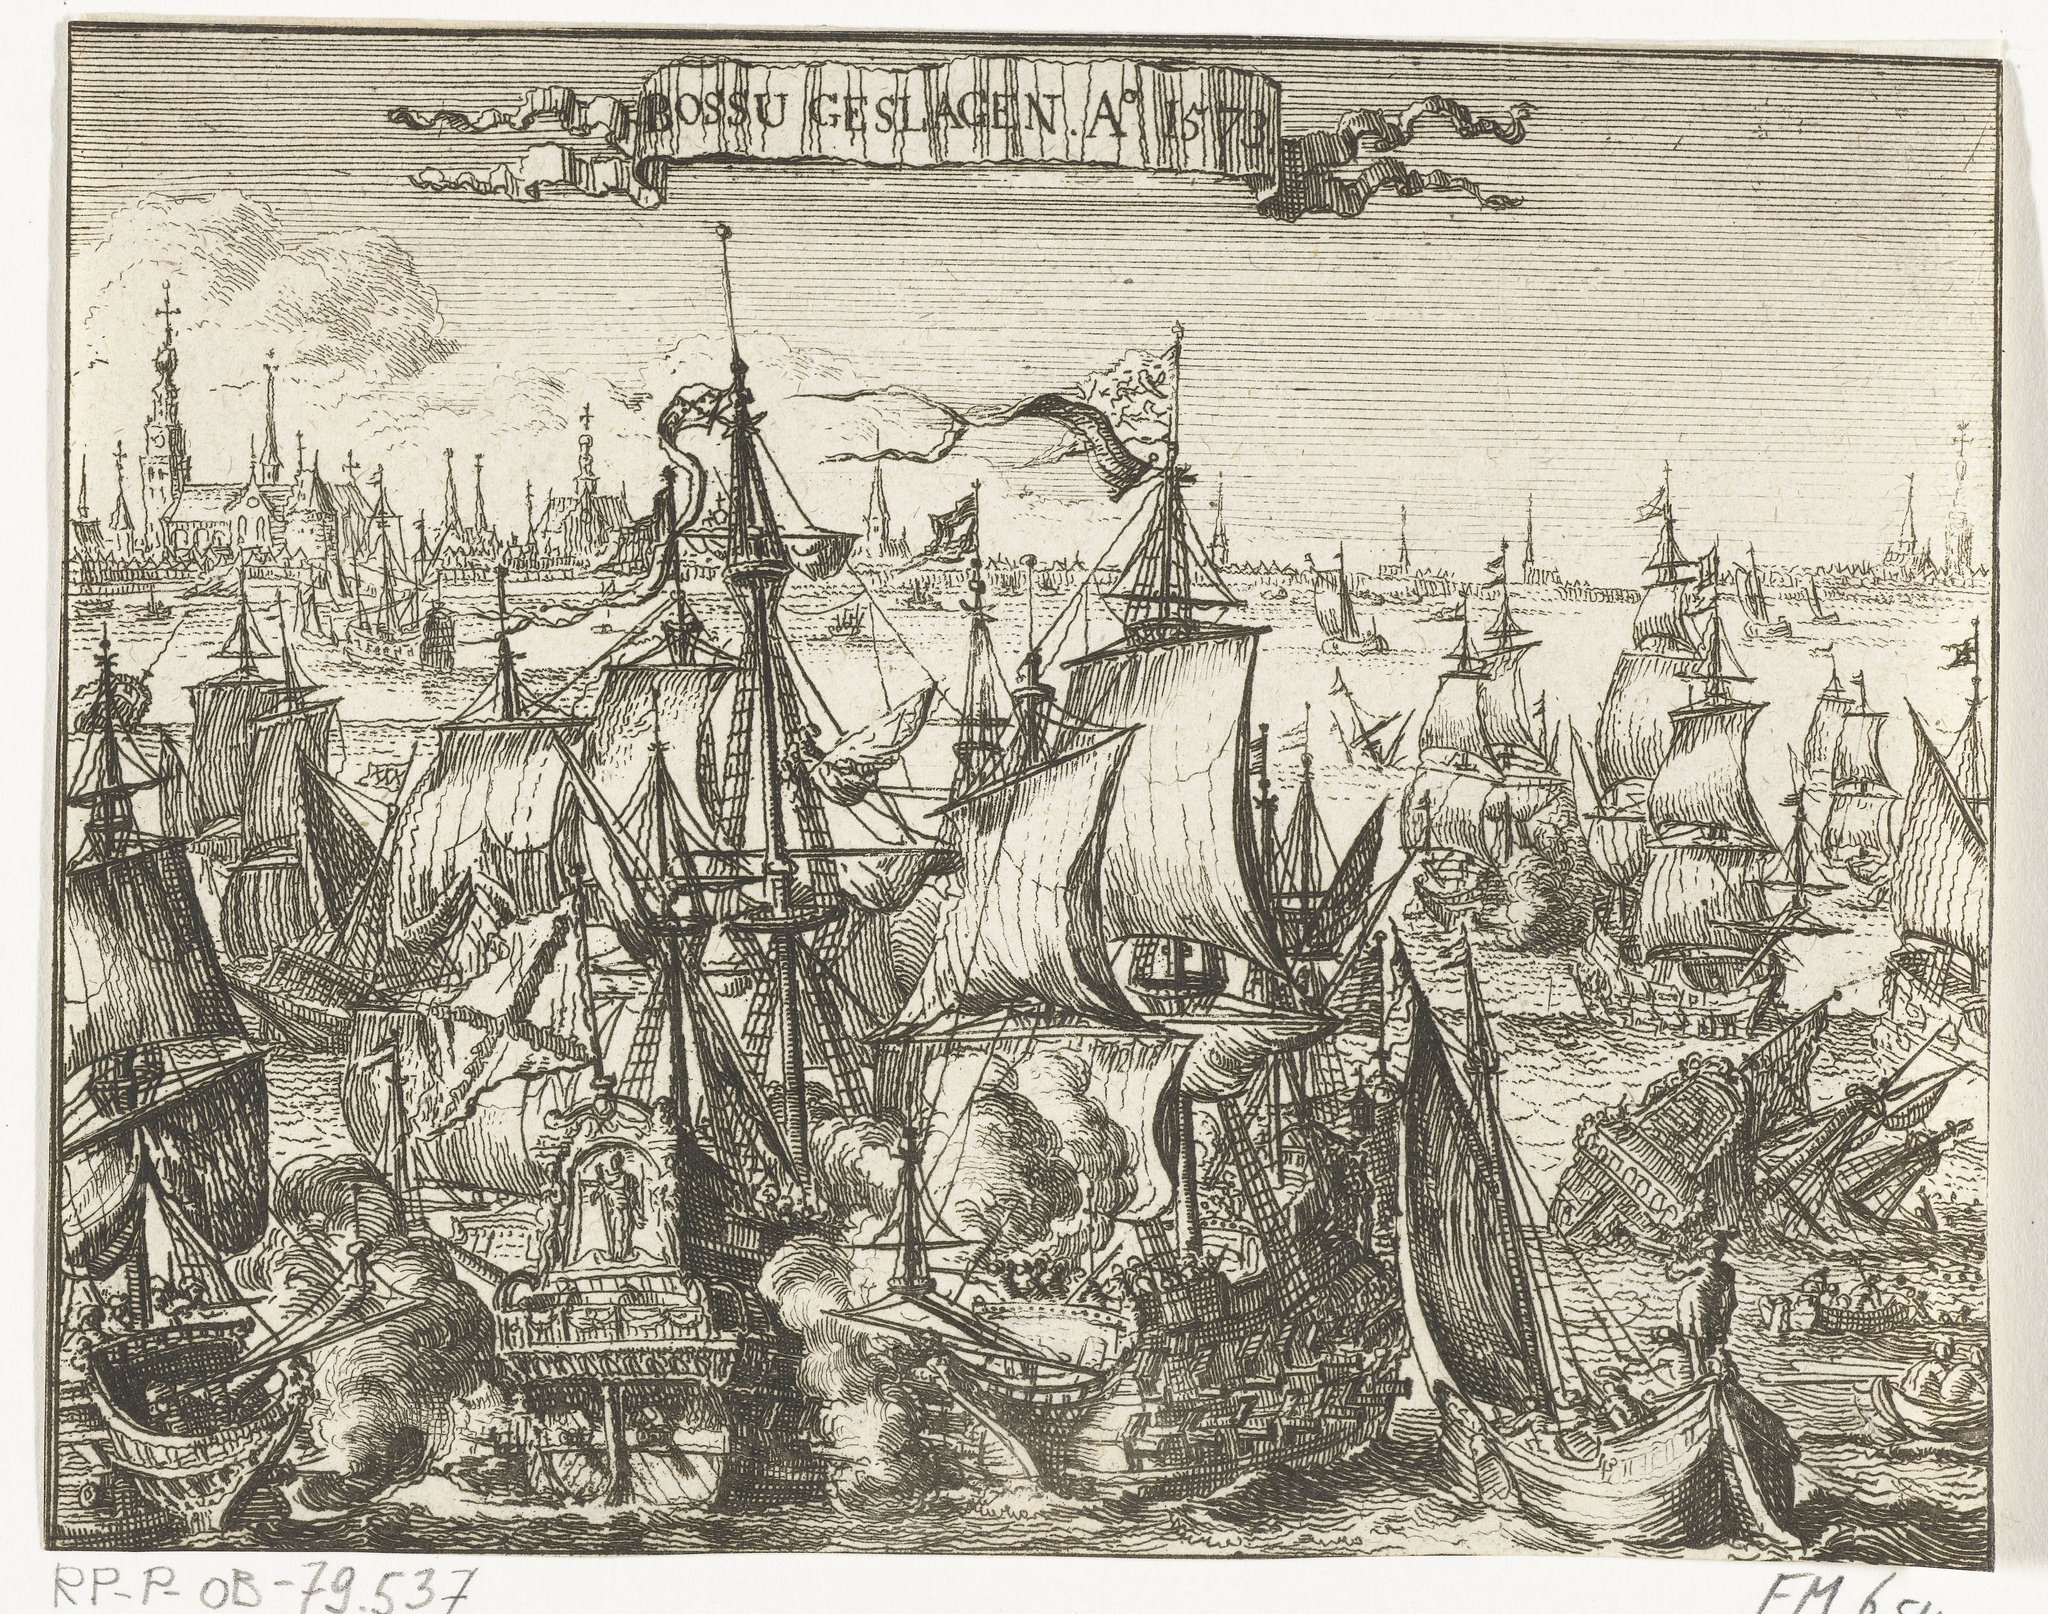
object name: history print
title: Bossu geslagen. Ao. 1573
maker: romeyn de hooghe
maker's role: draughtsman, goldsmith, painter, print maker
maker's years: 1645-1708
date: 1704-1706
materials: paper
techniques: etching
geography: northern netherlands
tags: antwerp, earl, politician, battle (+ naval force), zuiderzee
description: De slag op de Zuiderzee, 11 oktober 1573. Zeeslag waarbij de vloot van de watergeuzen onder leiding van Cornelis Dirkszoon van Monnickendam de Spaanse vloot van Bossu verslaat. Op de voorgrond vuren schepen op elkaar. Links op de achtergrond Hoorn.